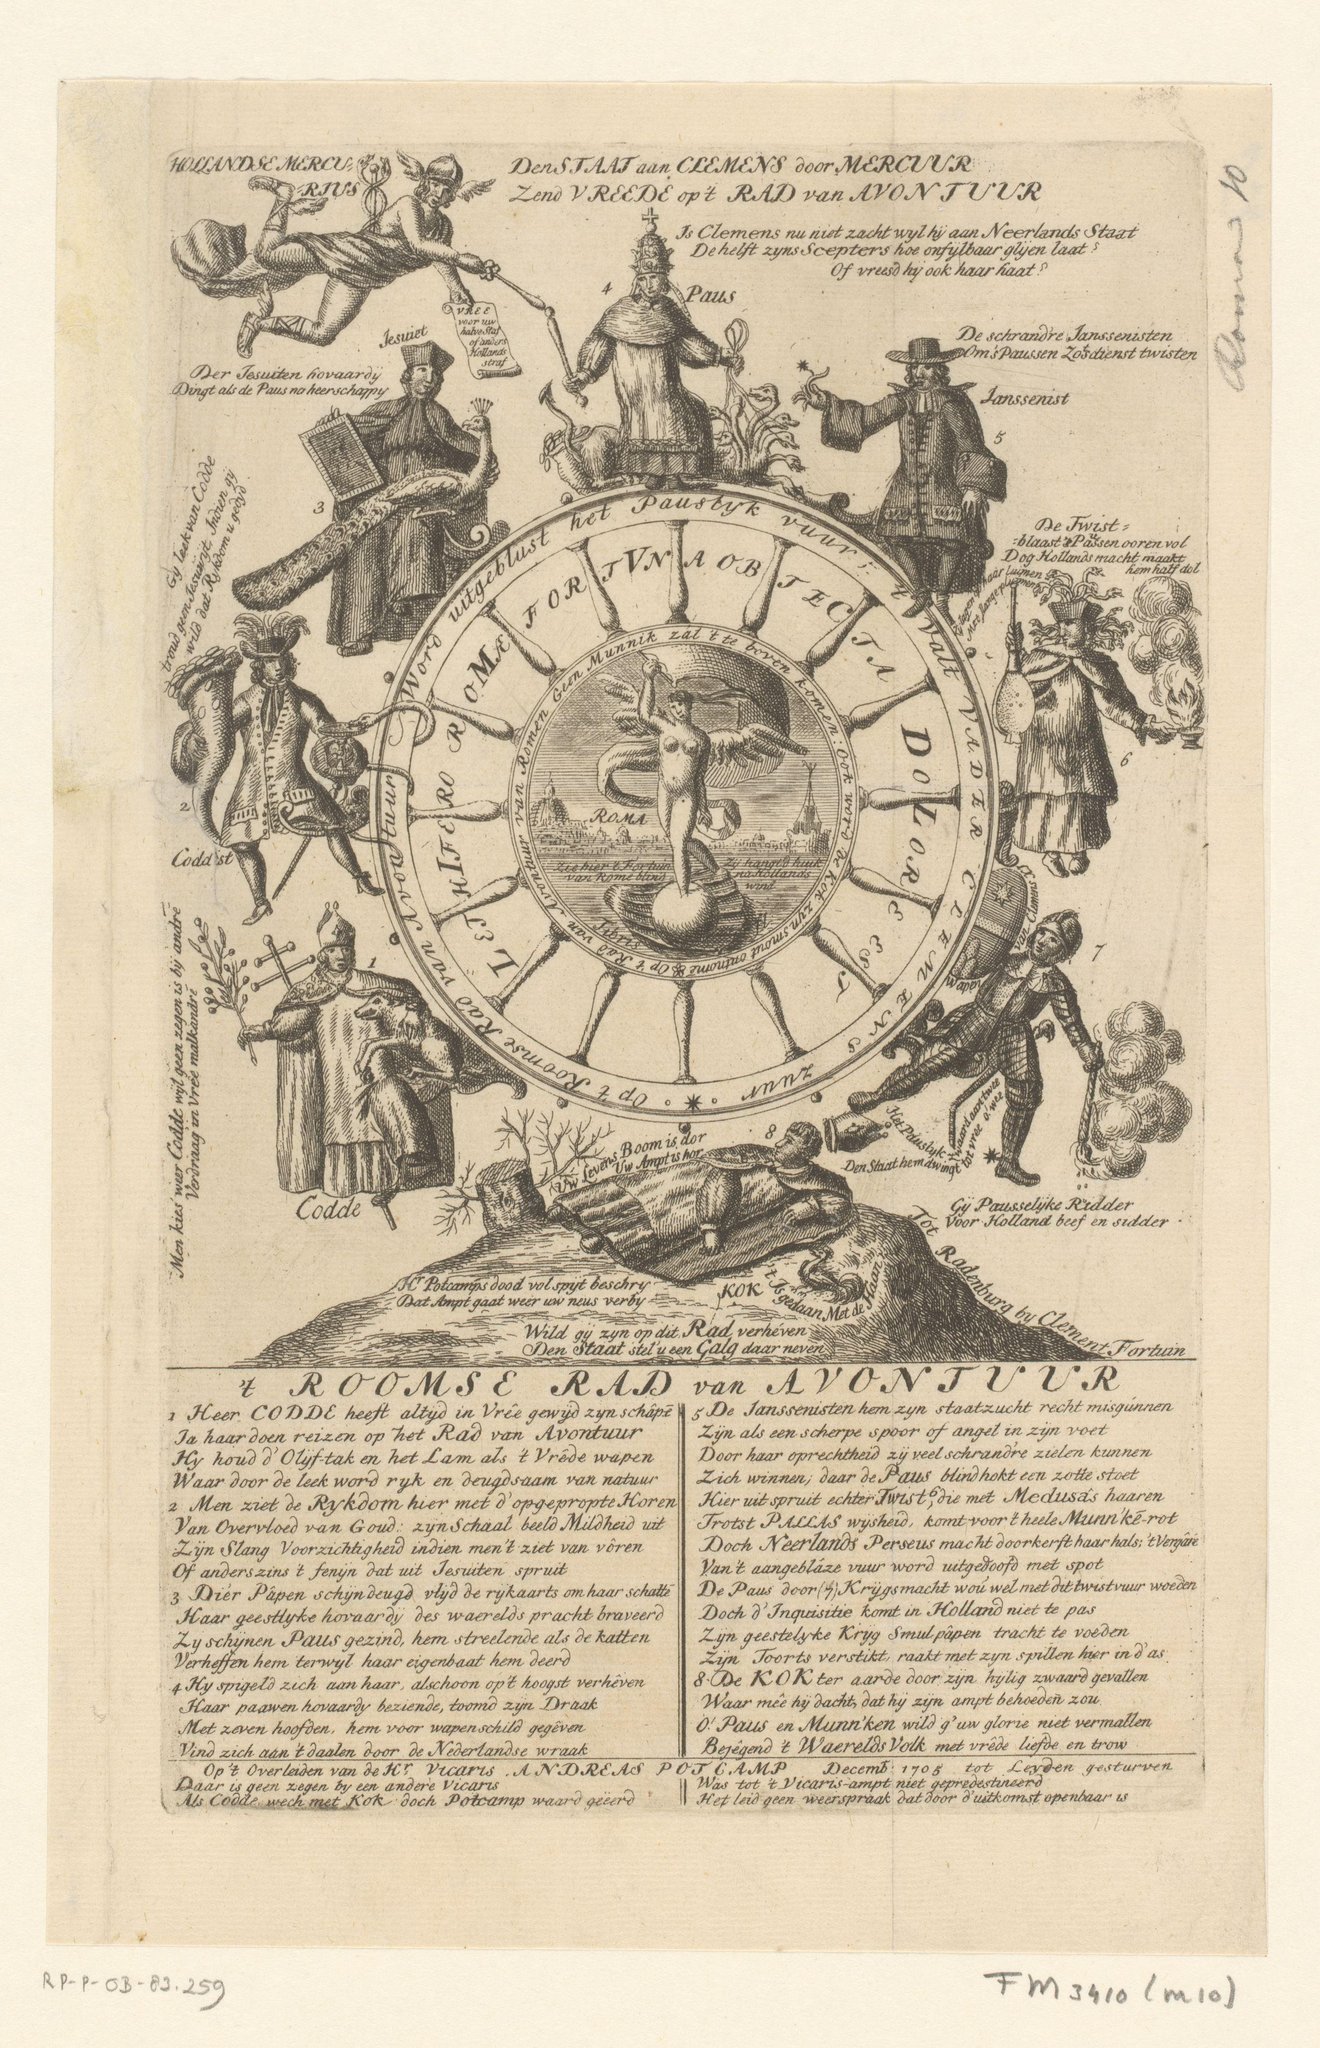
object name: print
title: 10 Zinnebeeld, of 't Roomse Rad van Avontuur. Het Tiende Gebod overtreeden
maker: carel allard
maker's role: print maker, publisher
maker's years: 1648-1709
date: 1706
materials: paper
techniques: etching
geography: amsterdam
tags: utrecht, rome, turn of fate, wheel of fortune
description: Het Roomse Rad van Avontuur, 1705. Theodorus de Cock liggend op de grond ziet boven hem een rad van avontuur met Petrus Codde, de jezuïet, de paus, de jansenist en anderen. Onder het vers wordt melding gemaakt van het overlijden van de vicaris Gerardus Potcamp te Leiden op 16 december 1705. Tiende blad in de serie van 10 bladen met spotprenten op de jezuïeten getiteld Roma Pertubata, 1706.